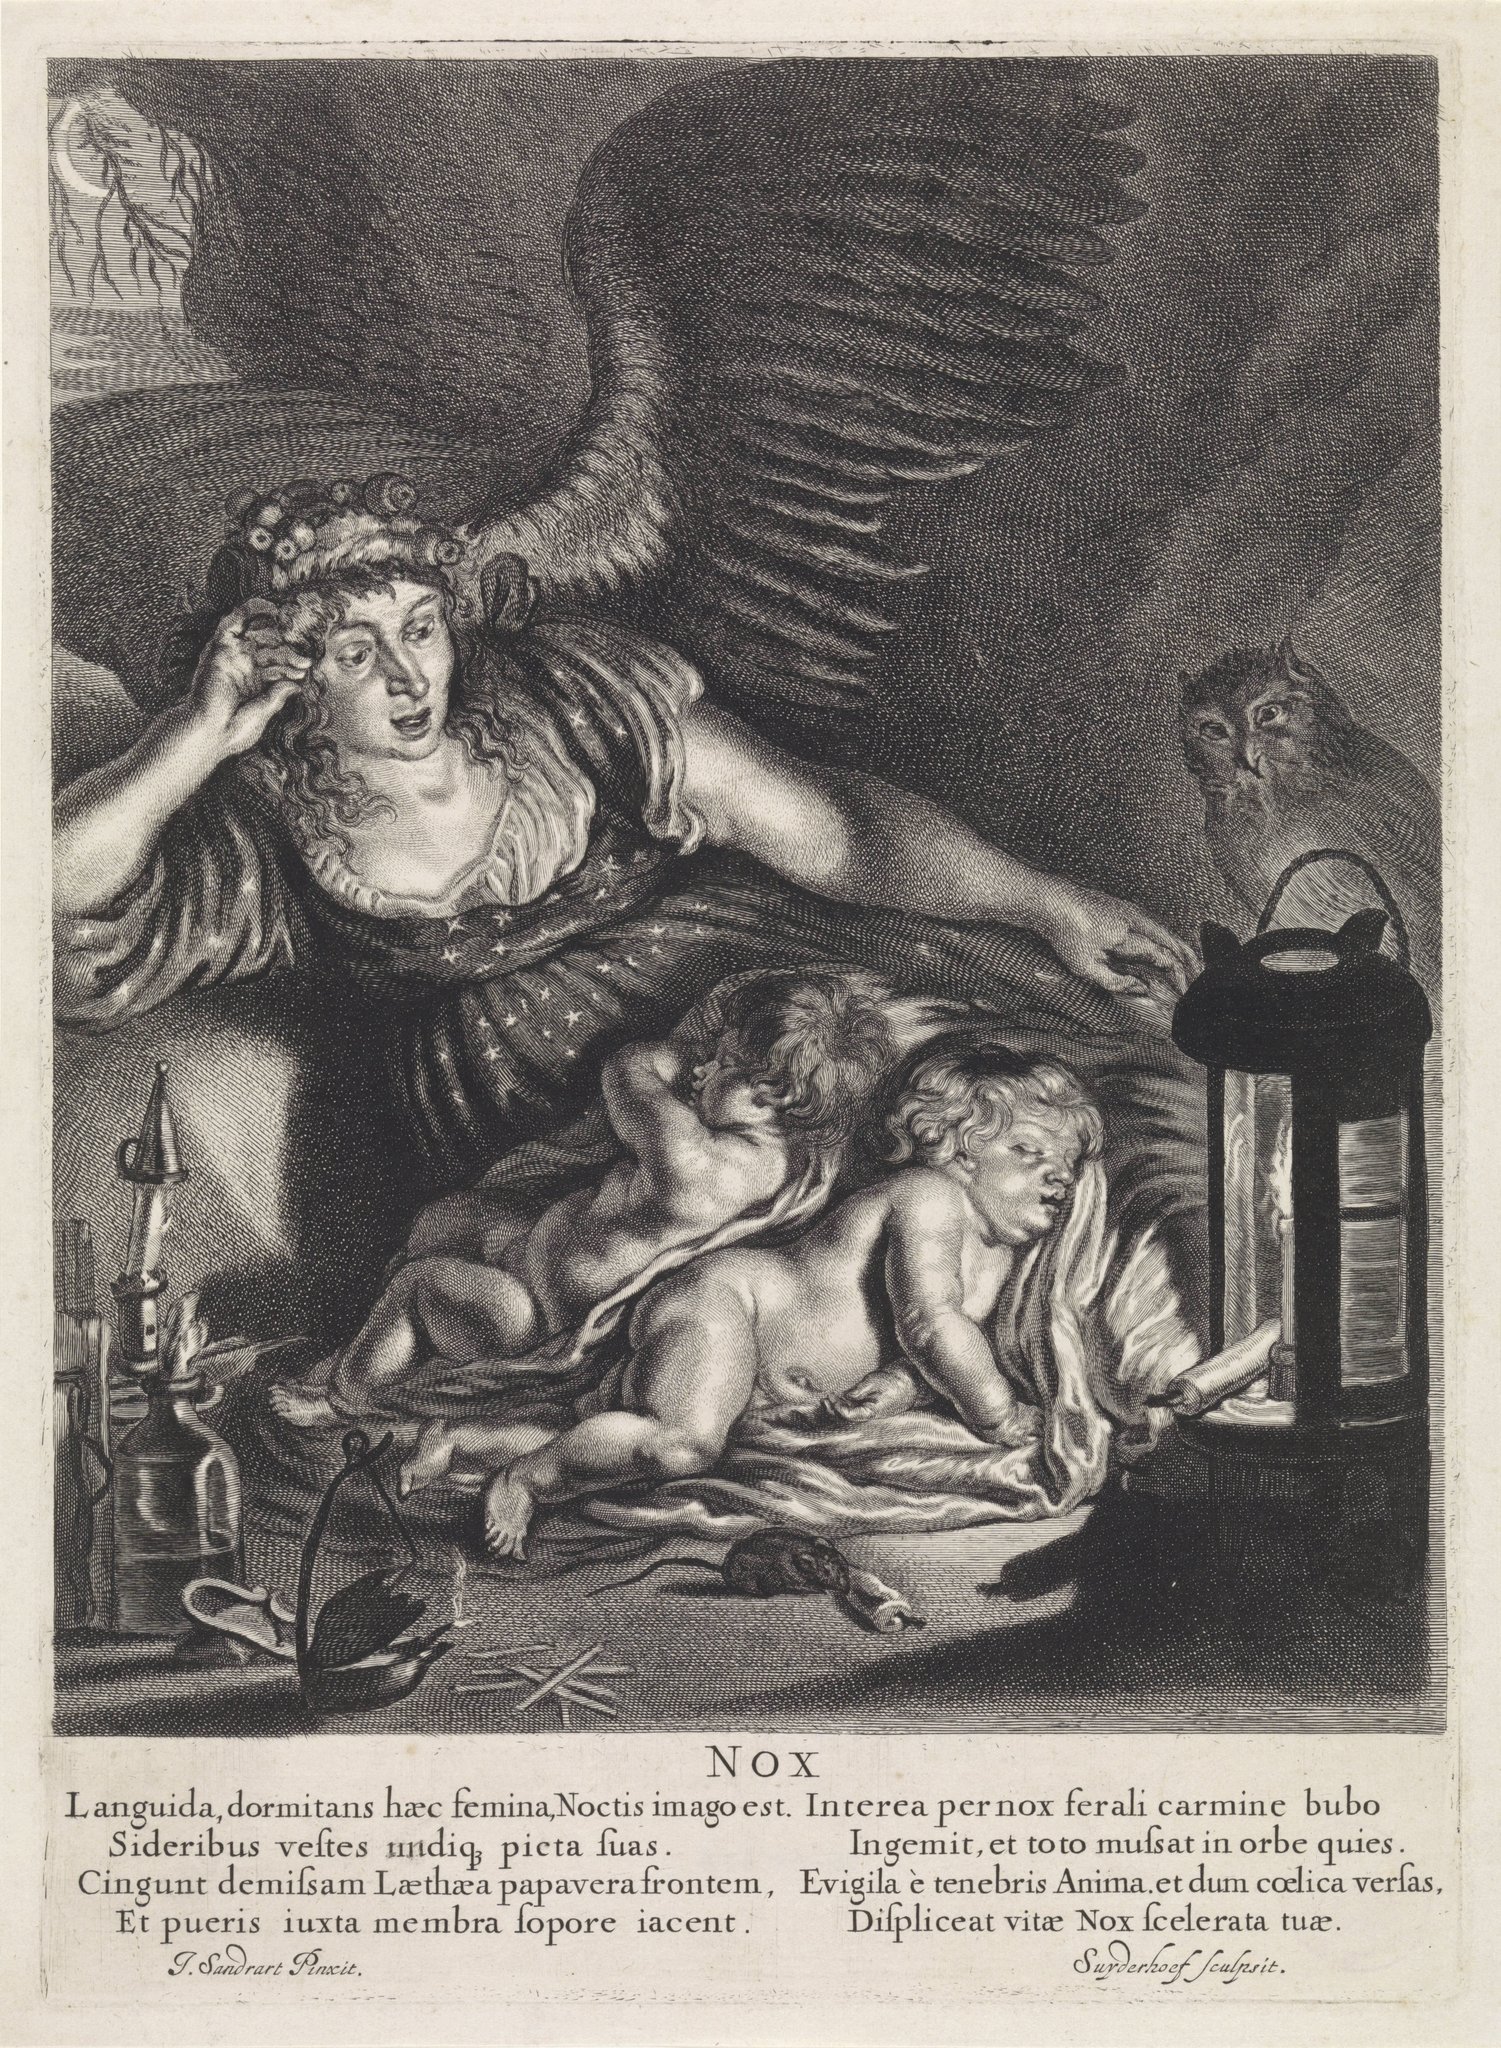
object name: print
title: Nox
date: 1645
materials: paper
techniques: engraving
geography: amsterdam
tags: personification of the night, 'nox'; 'notte', 'carro della notte', 'serenità della notte' (ripa), owls, sleeping; unconsciousness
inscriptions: collector's mark: Lugt 240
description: Joachim van Sandrart gaf de prenten naar zijn schilderijen van de twaalf maanden, de dag en de nacht, zelf uit in 1645. Zij werden vervaardigd door verschillende graveurs: Theodor Matham, Reinier van Persijn, Jonas Suyderhoef, Jeremias Falck, Cornelis van Dalen (II) en Albert Haelwegh.